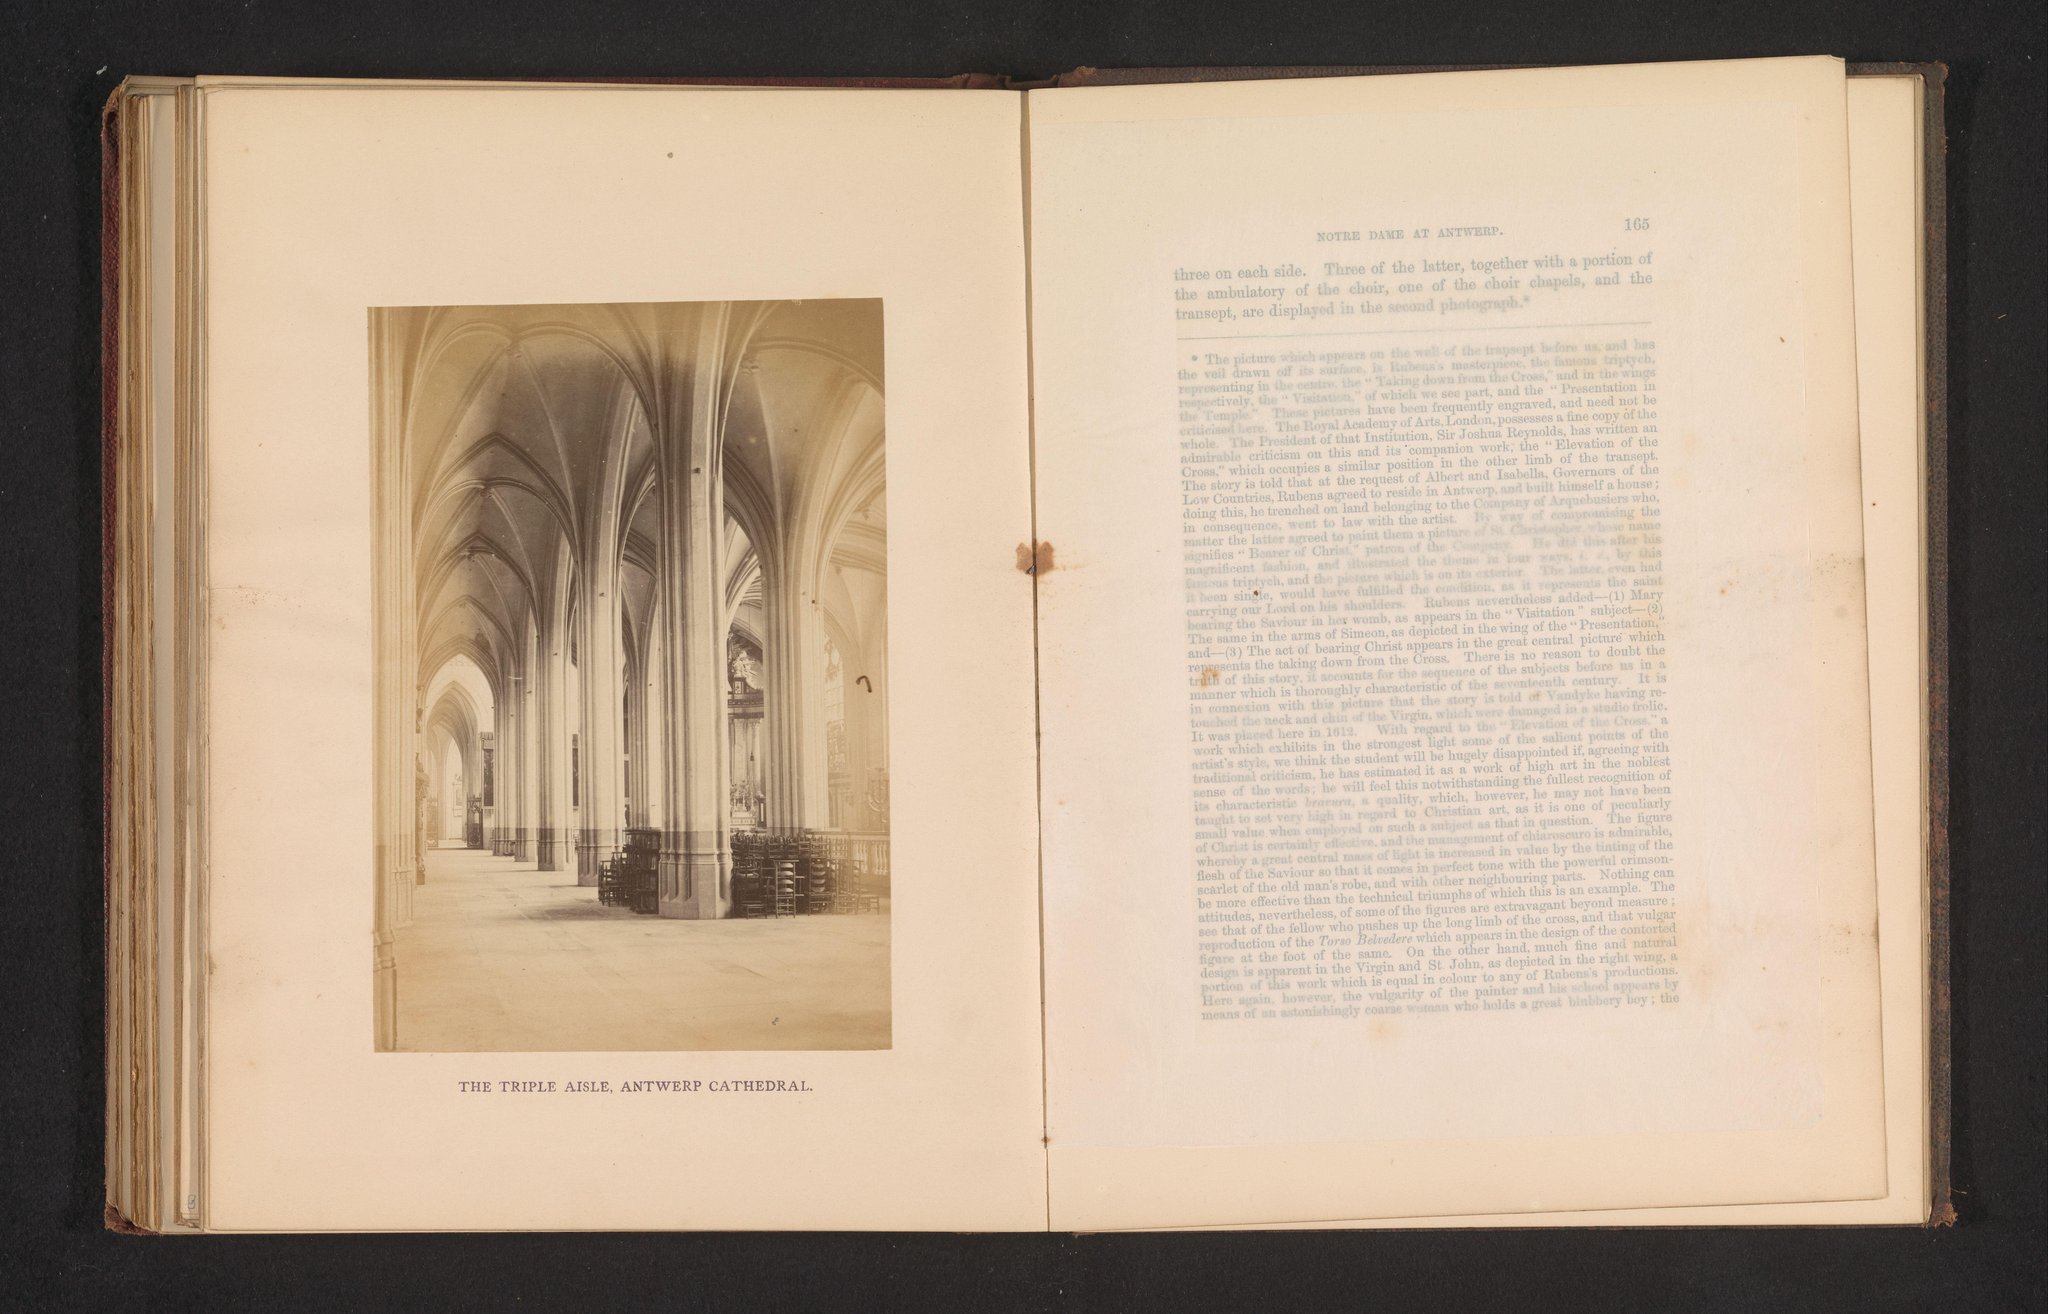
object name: photograph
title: The triple aisle, Antwerp cathedral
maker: Anonymous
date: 1856-1866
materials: photographic support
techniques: albumen print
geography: antwerp cathedral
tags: parts of church interior: aisle, interior of church